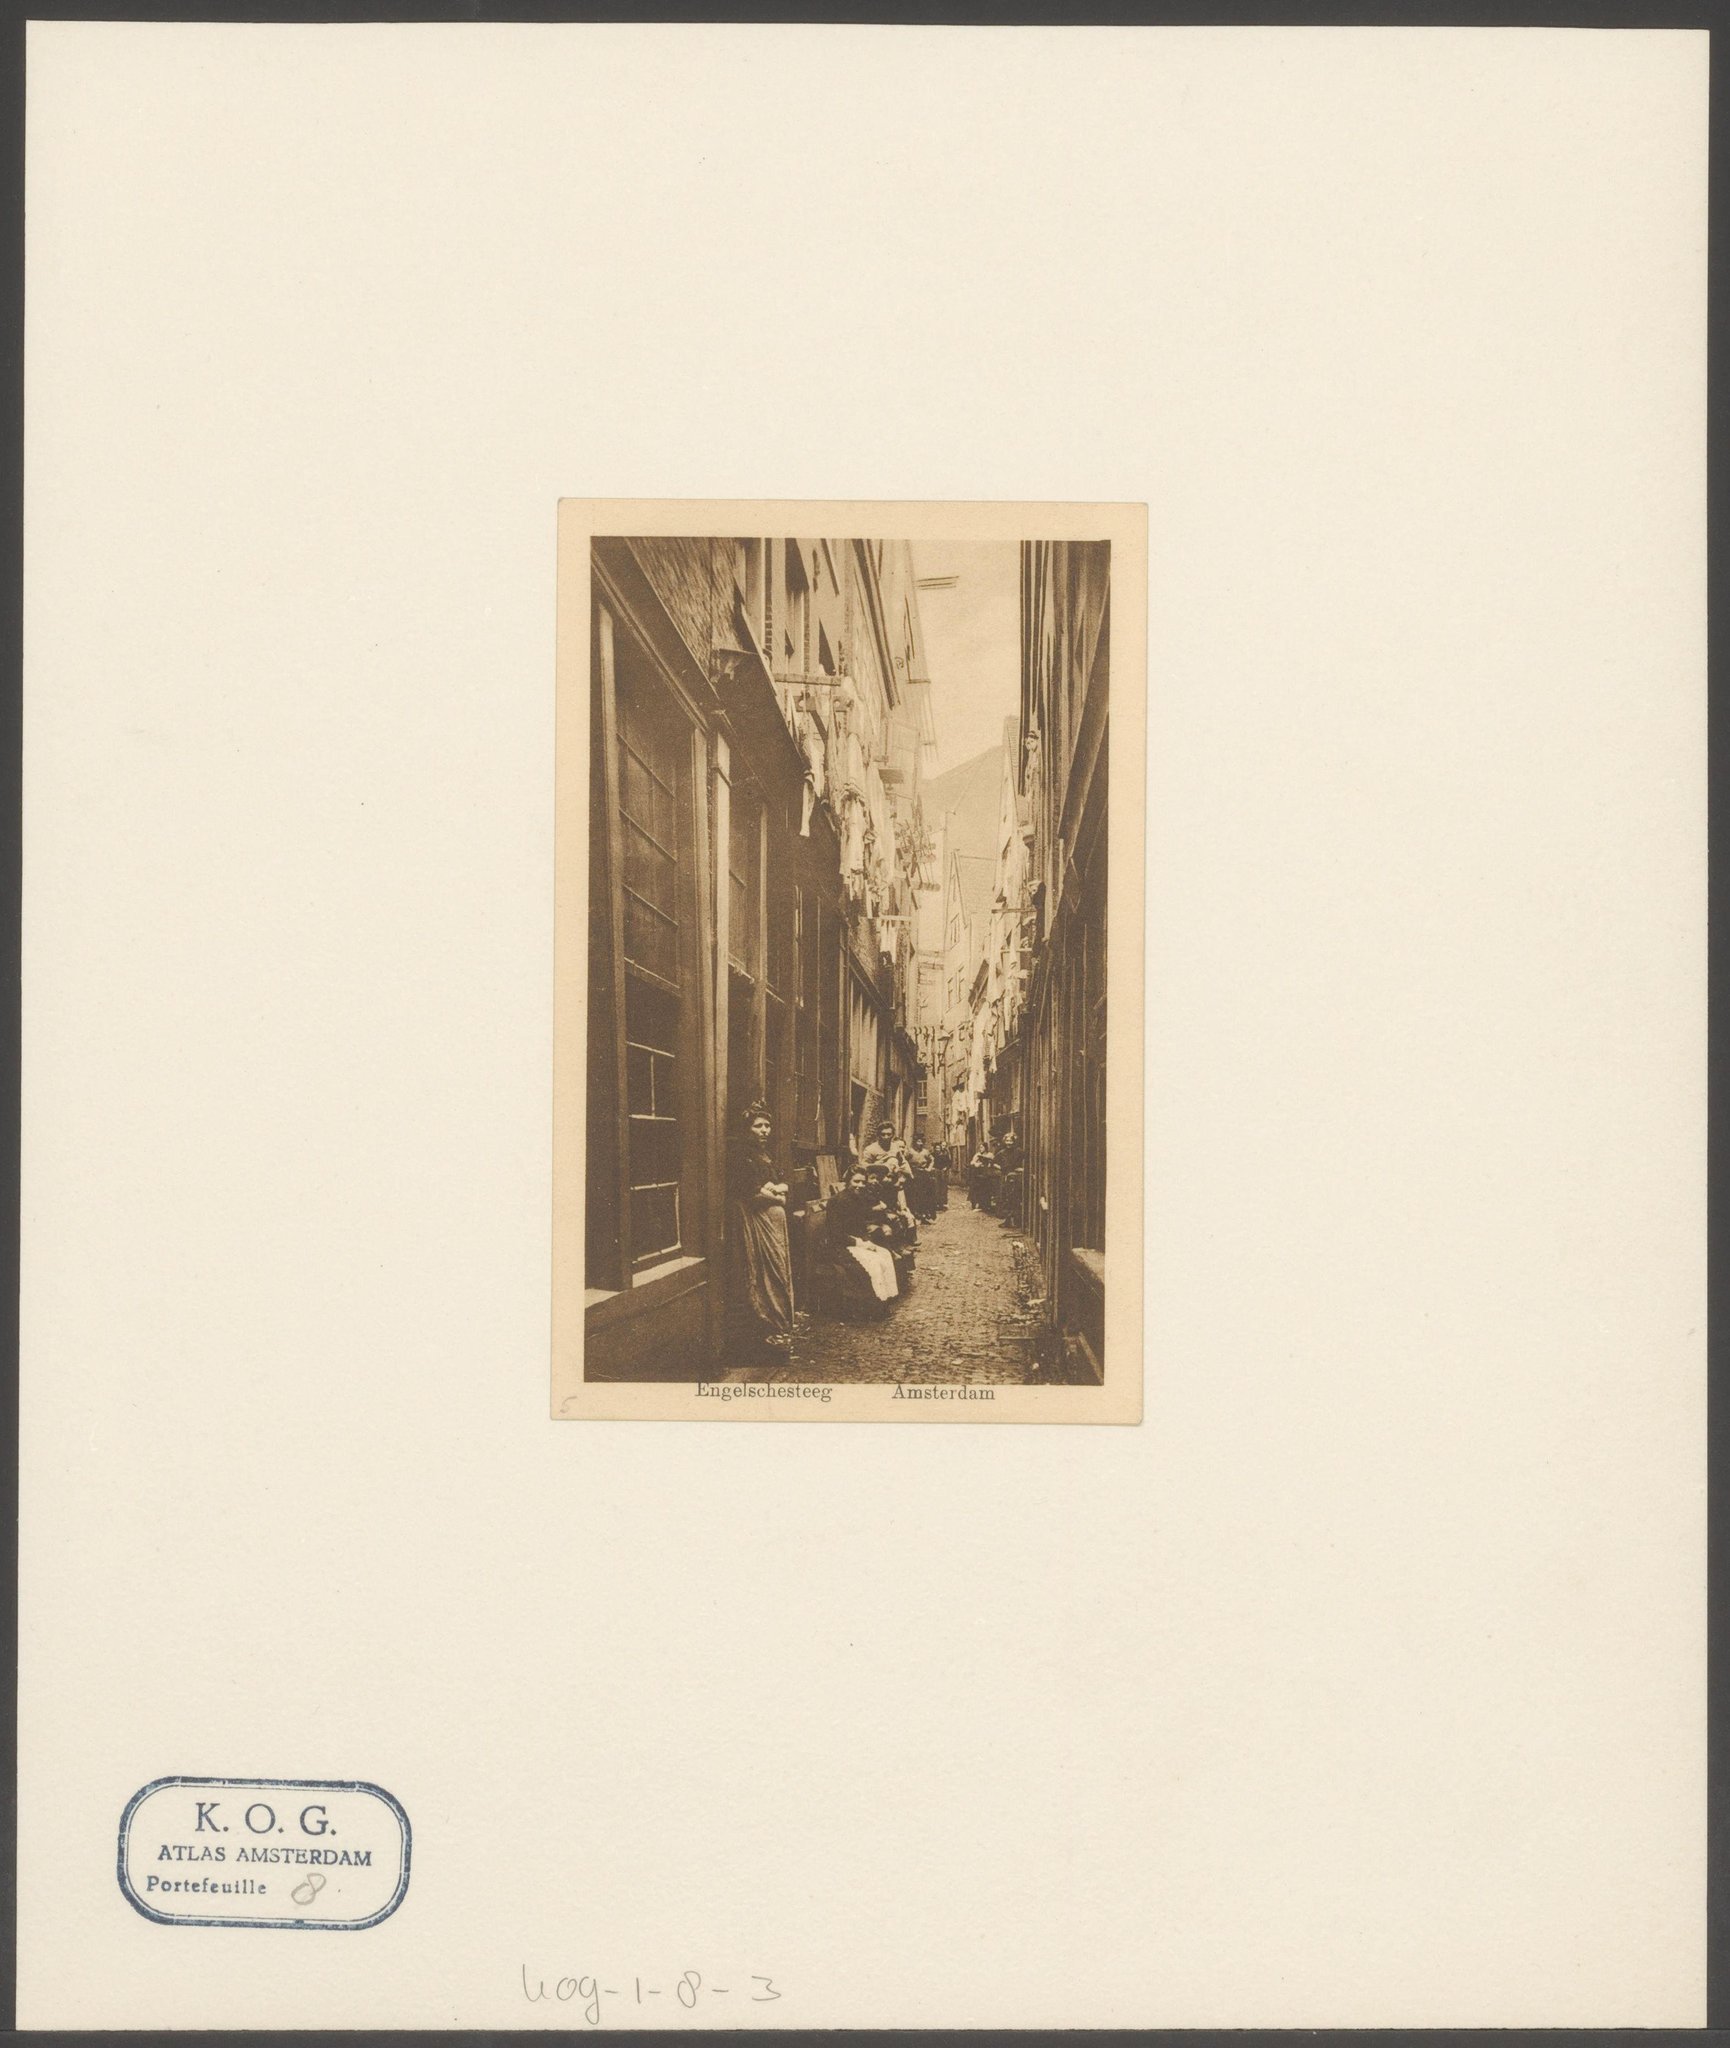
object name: ansichtkaart, prentbriefkaart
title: Gezicht op de Engelsesteeg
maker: Anonymous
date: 1875-1950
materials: cardboard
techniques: photograph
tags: city-view in general; 'veduta', lane, alley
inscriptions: collector's mark: ‘8’ Lugt 1641b, collector's mark: ‘4’ Lugt 1641b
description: Onderwerpsrubriek binnen de Atlas Amsterdam: Egelantiersdwarsstraat, Egelantiersgracht, Elandsgracht, Engelschesteeg, Foeliedwarsstraat, Frederiksplein, Funen.